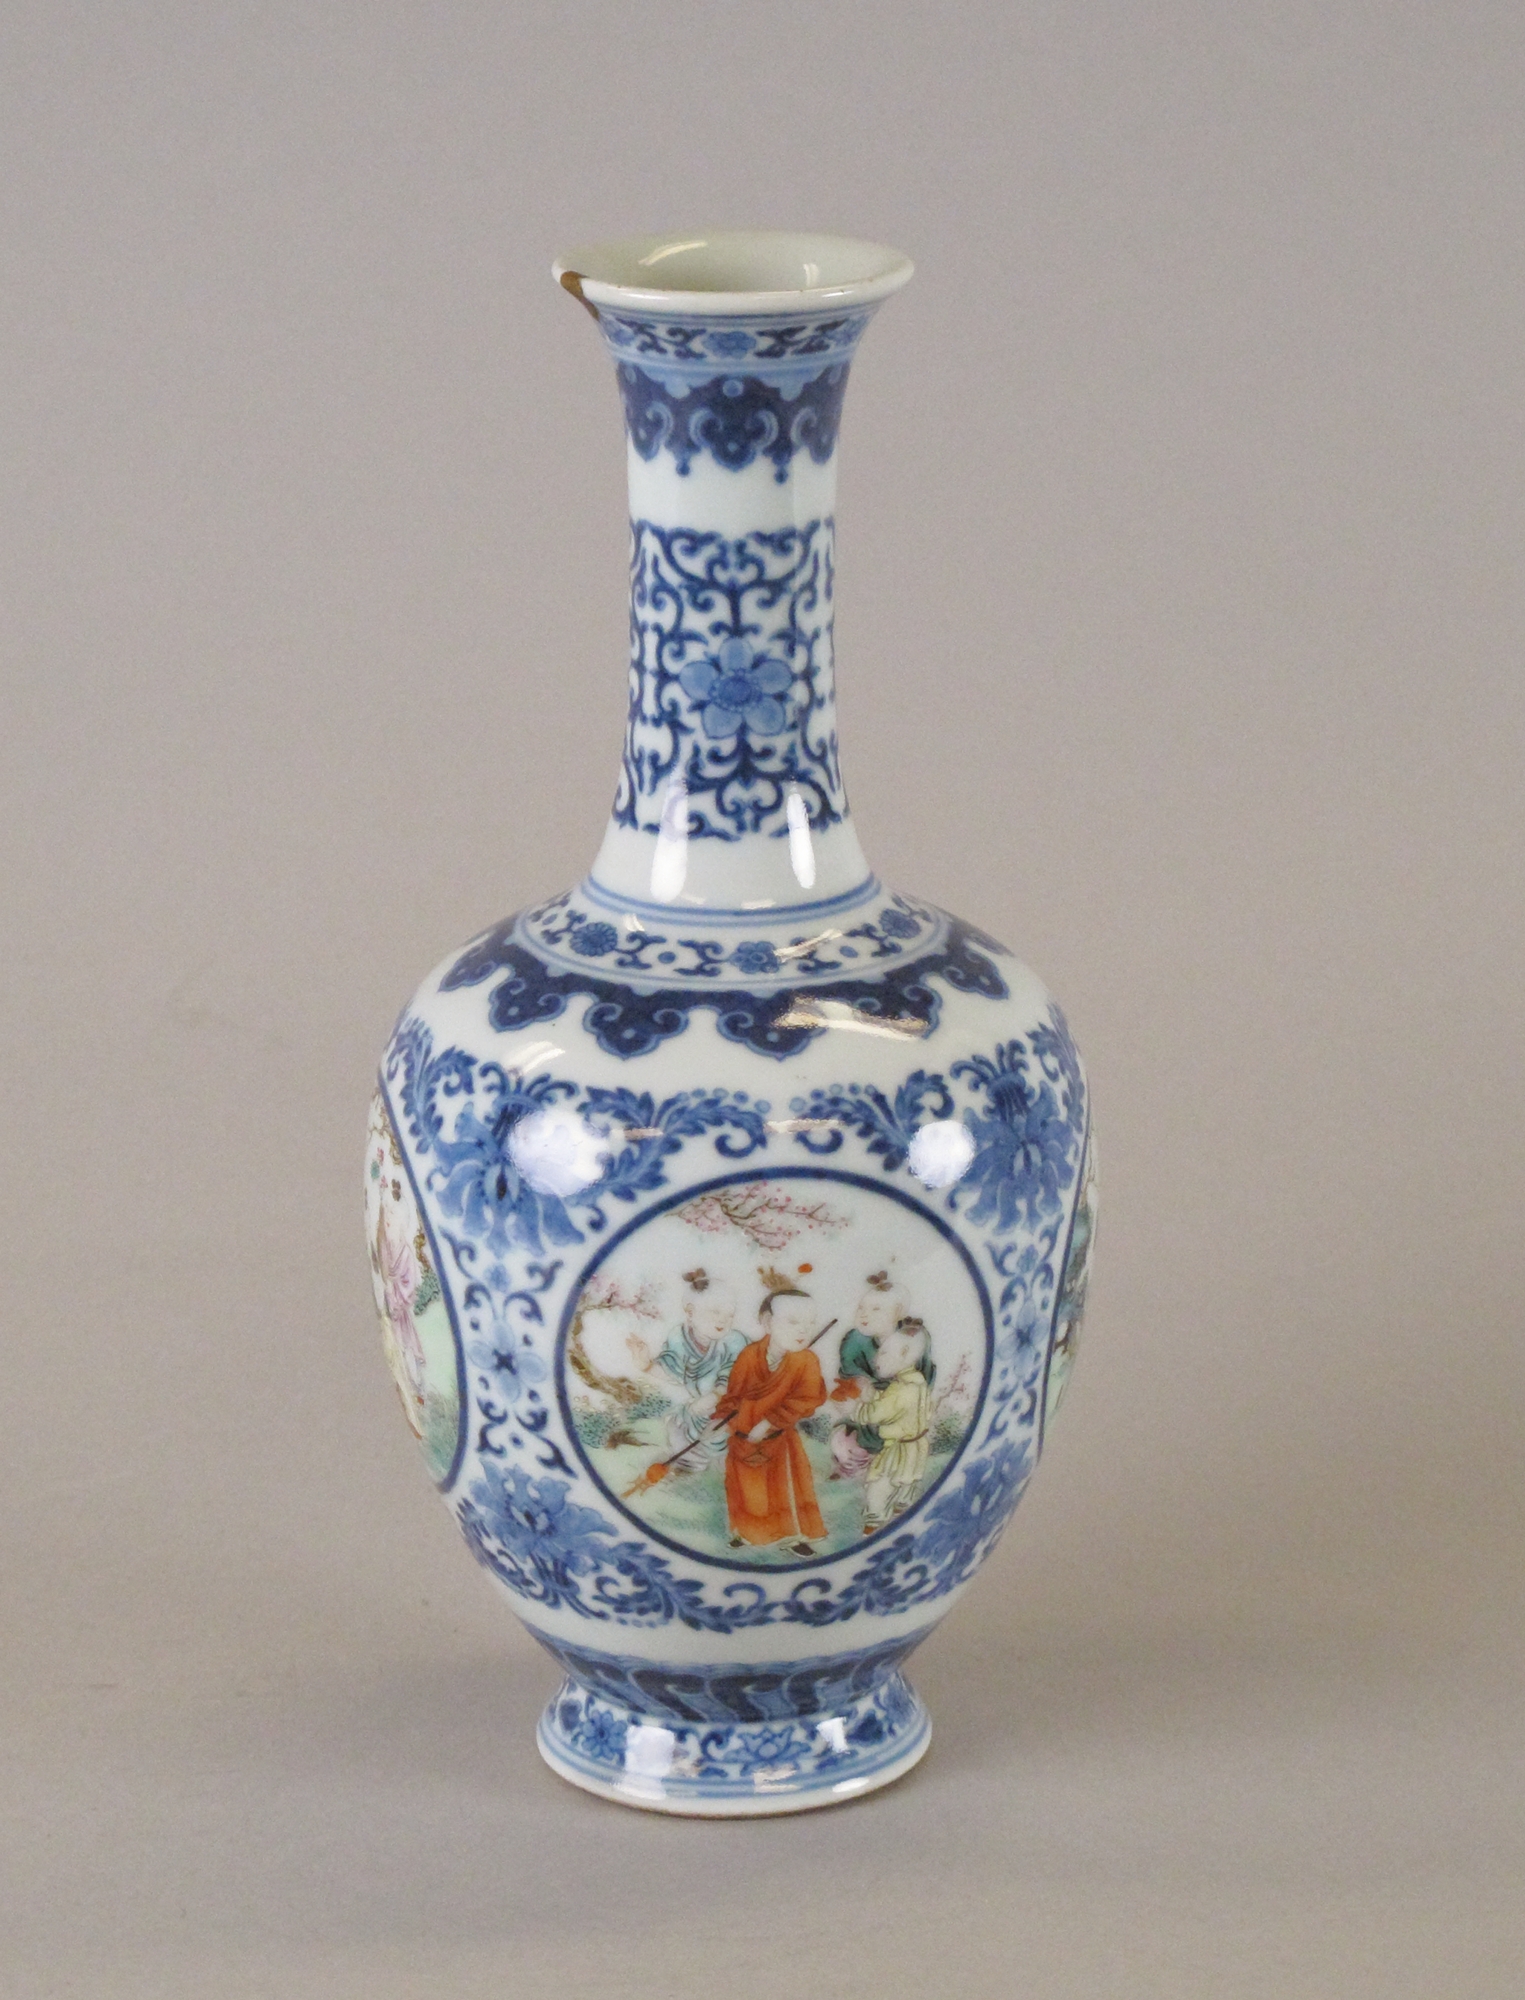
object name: vase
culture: chinese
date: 1767-1900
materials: enamel, porcelain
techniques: overglaze, painting, underglaze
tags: human figures,flowers